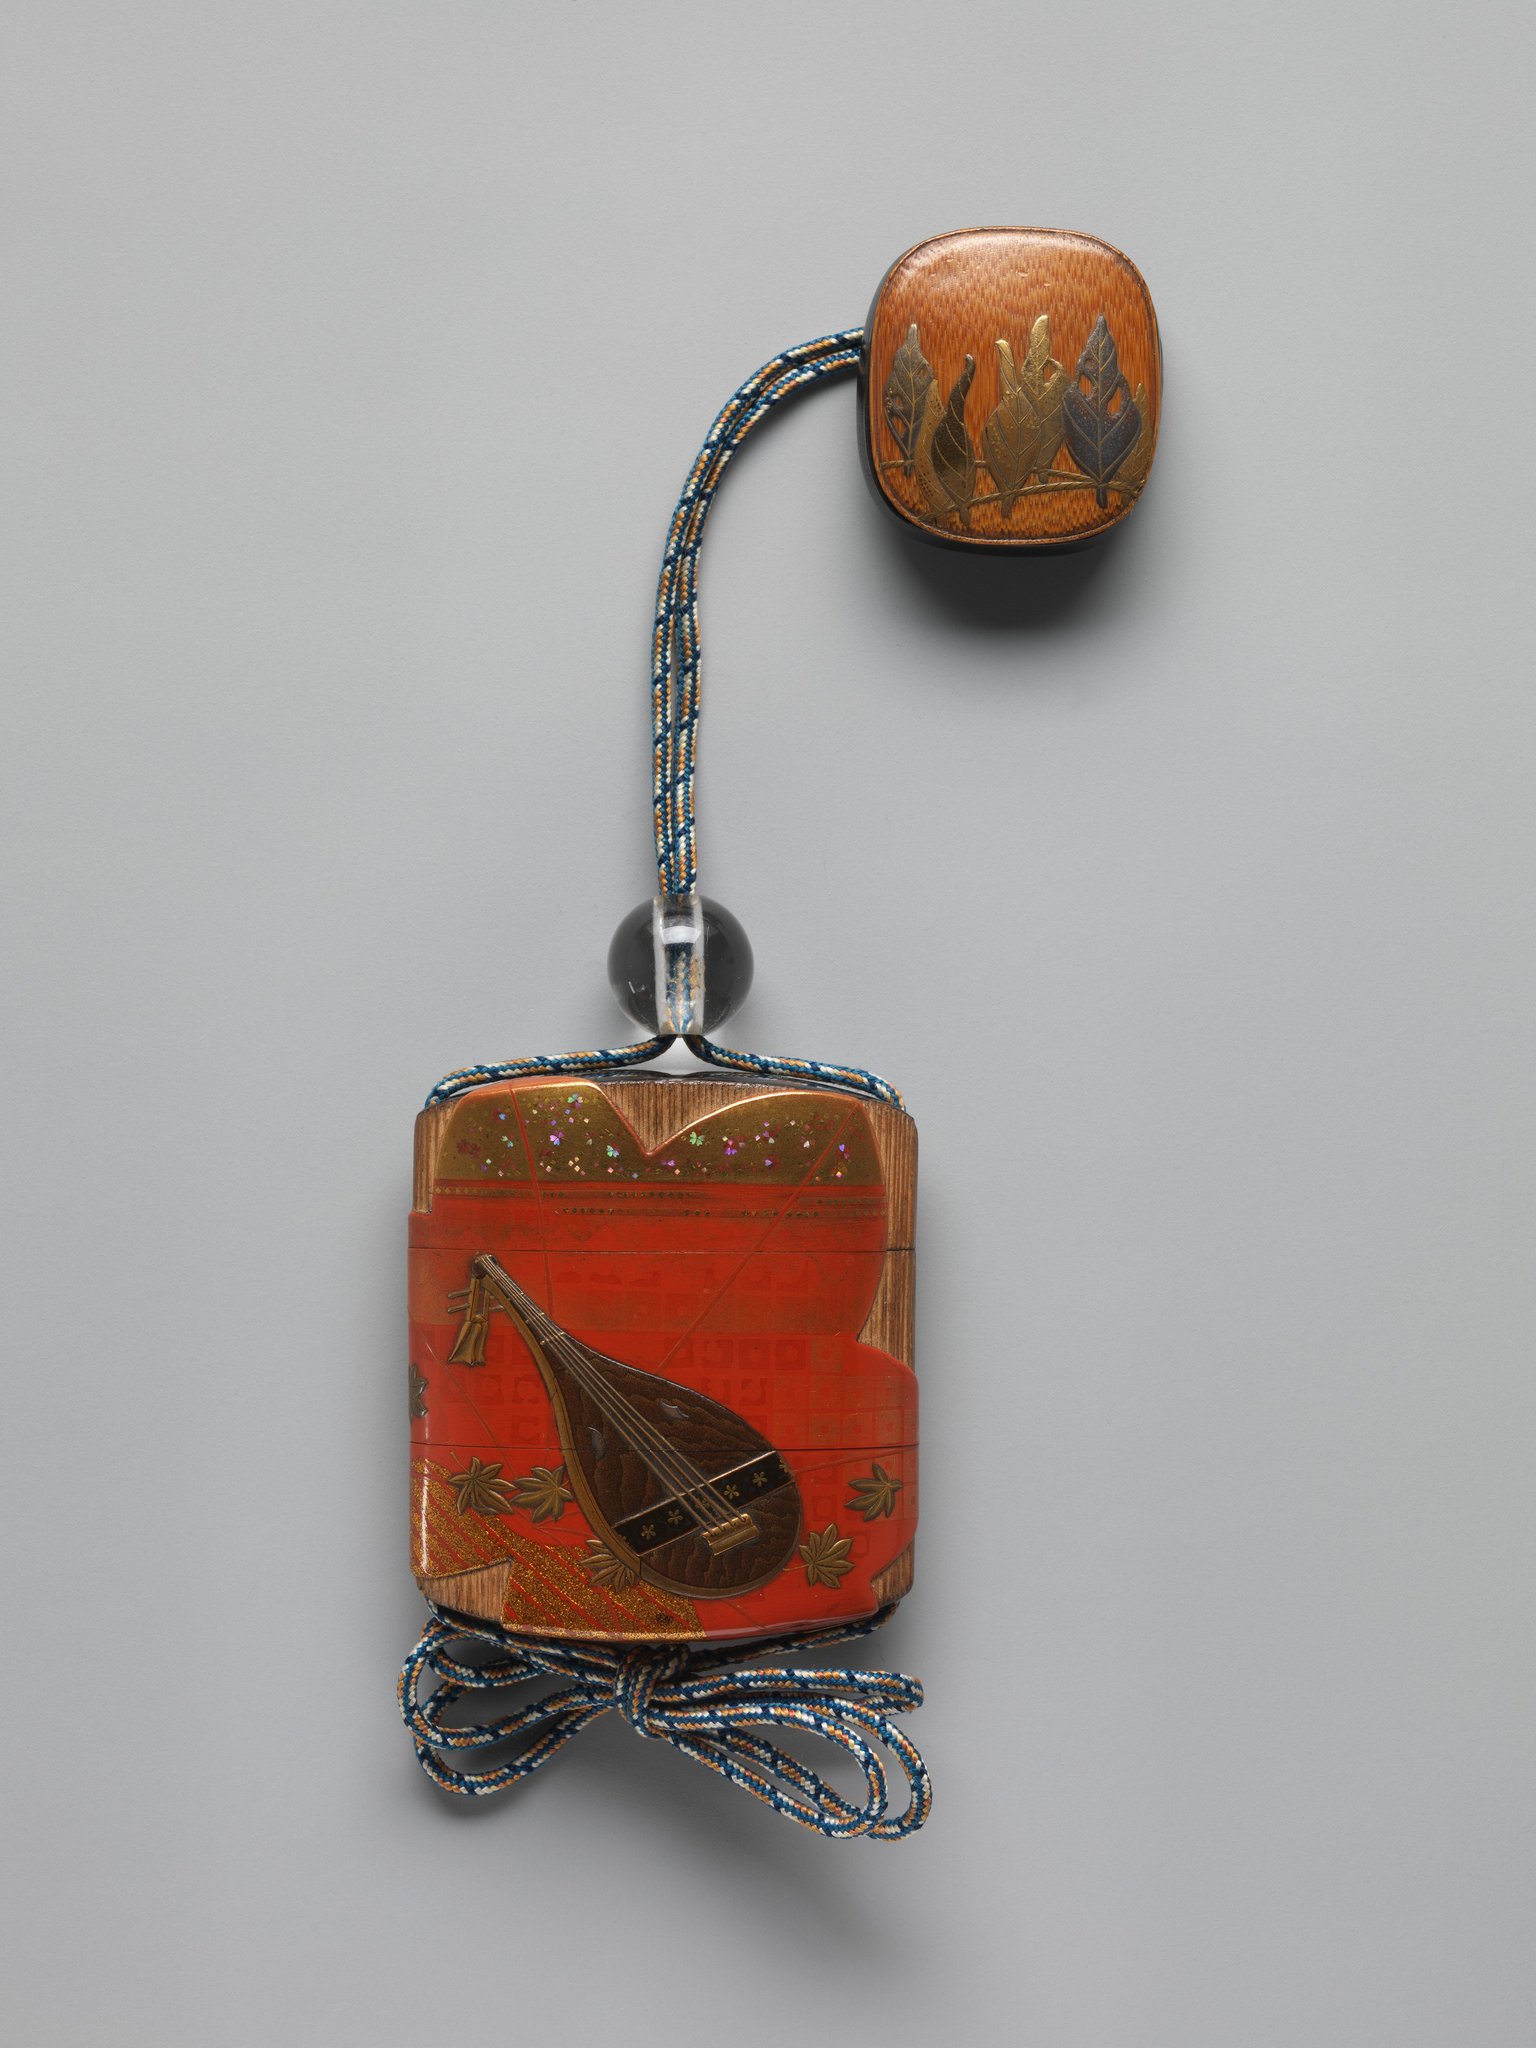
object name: inrō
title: Case (Inrō) with Design of Lute and Maple Leaves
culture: japanese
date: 1801-1900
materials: glass, gold, gold leaf, lacquer, mother of pearl, wood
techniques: inlay, maki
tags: lutes